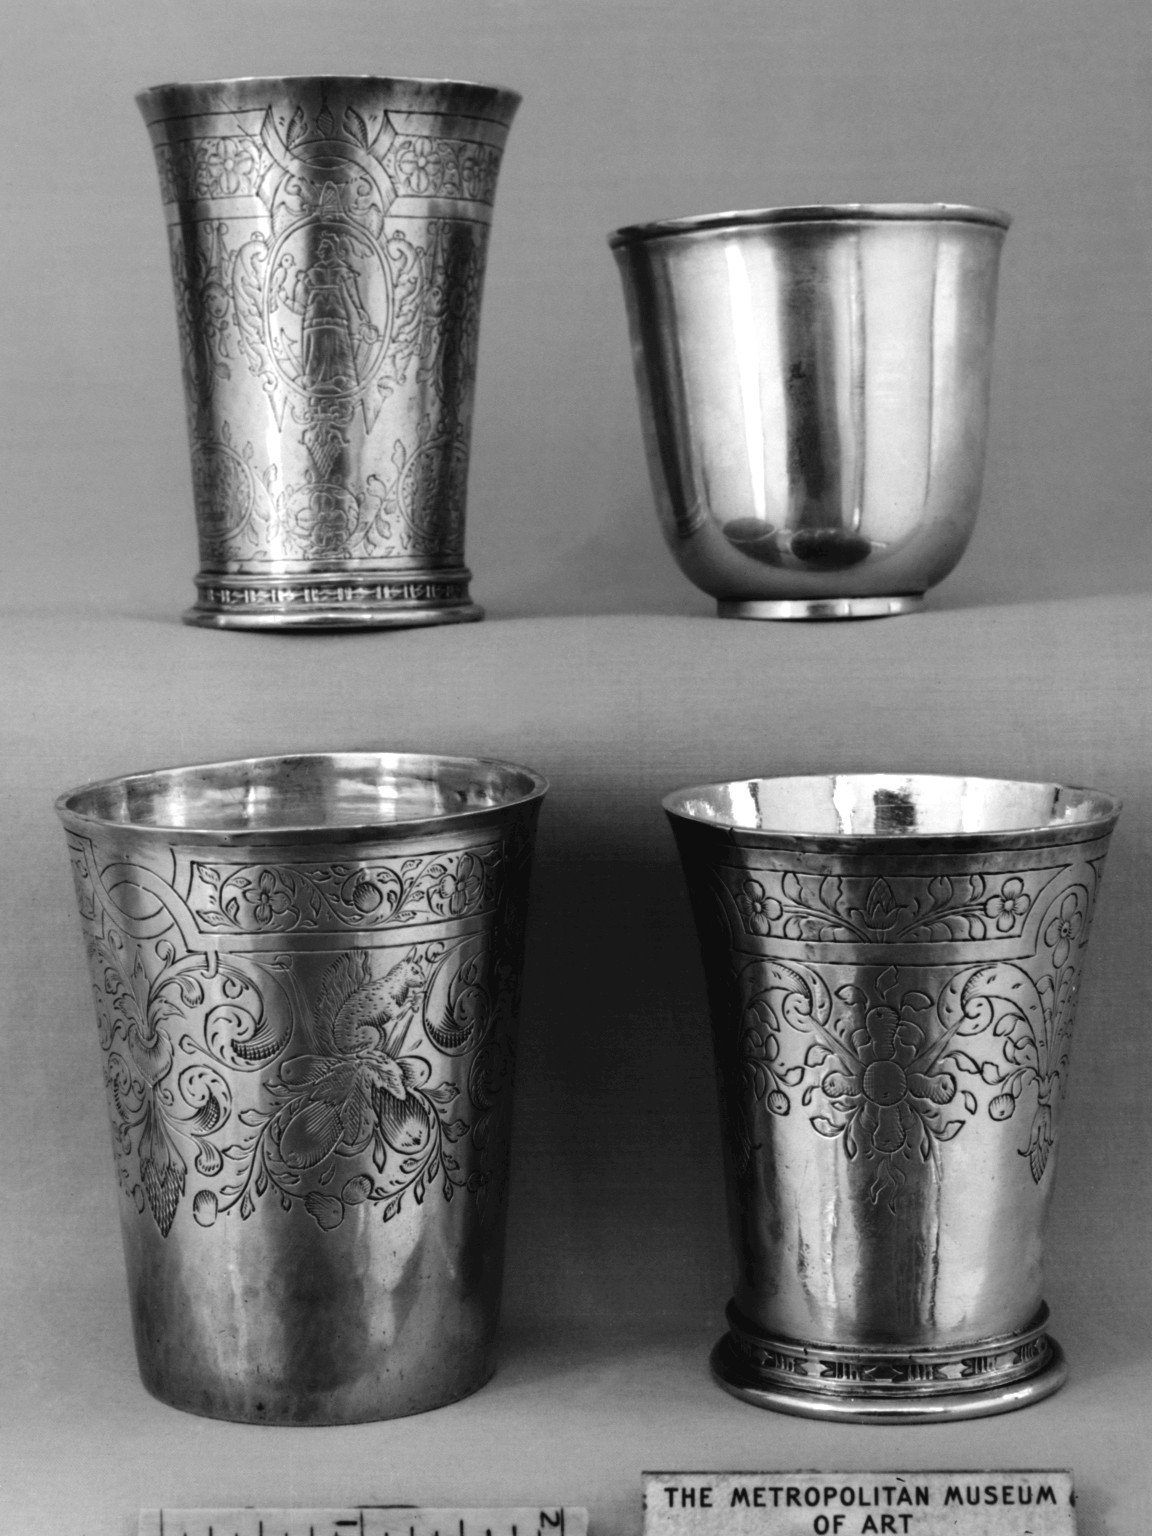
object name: beaker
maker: andreas pauli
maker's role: maker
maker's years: 1663-1669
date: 1622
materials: silver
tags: human figures,animals,flowers